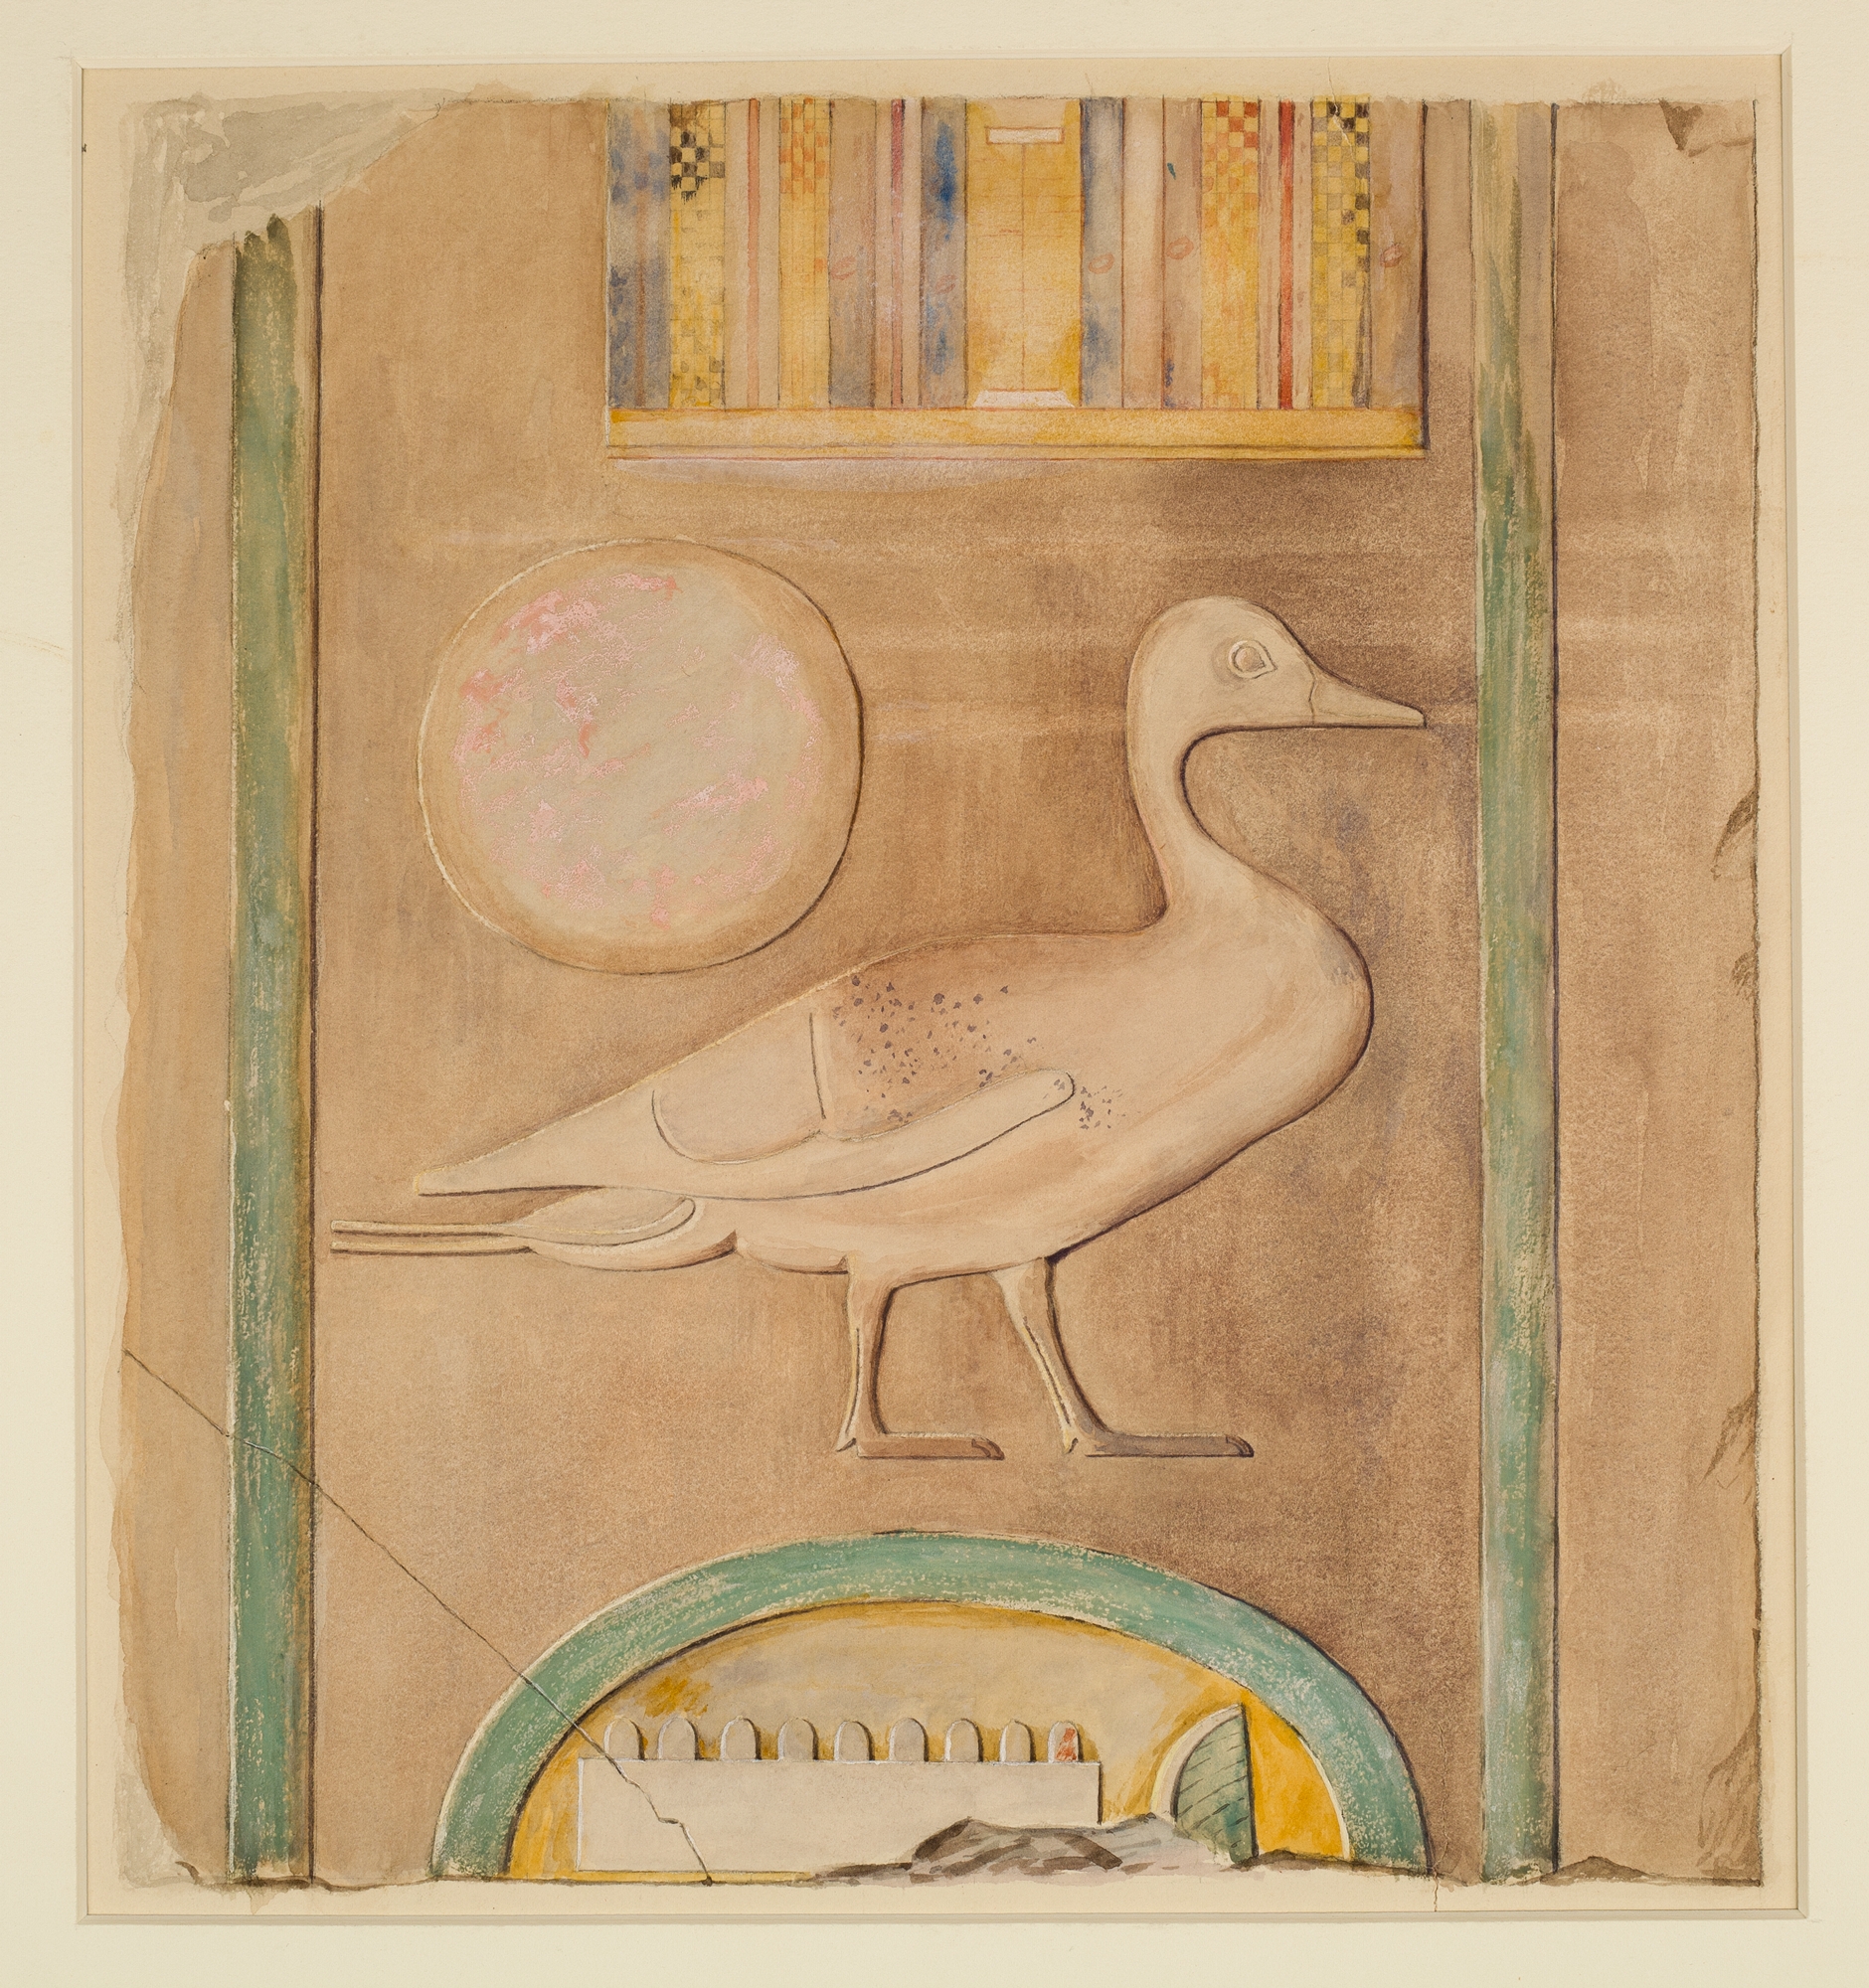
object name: facsimile, amenemhat i temple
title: Fragment of Inscription, Pyramid Temple of Amenemhat I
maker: unknown copyist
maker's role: artist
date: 1981-1952 BCE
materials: paper, paint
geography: egypt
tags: birds